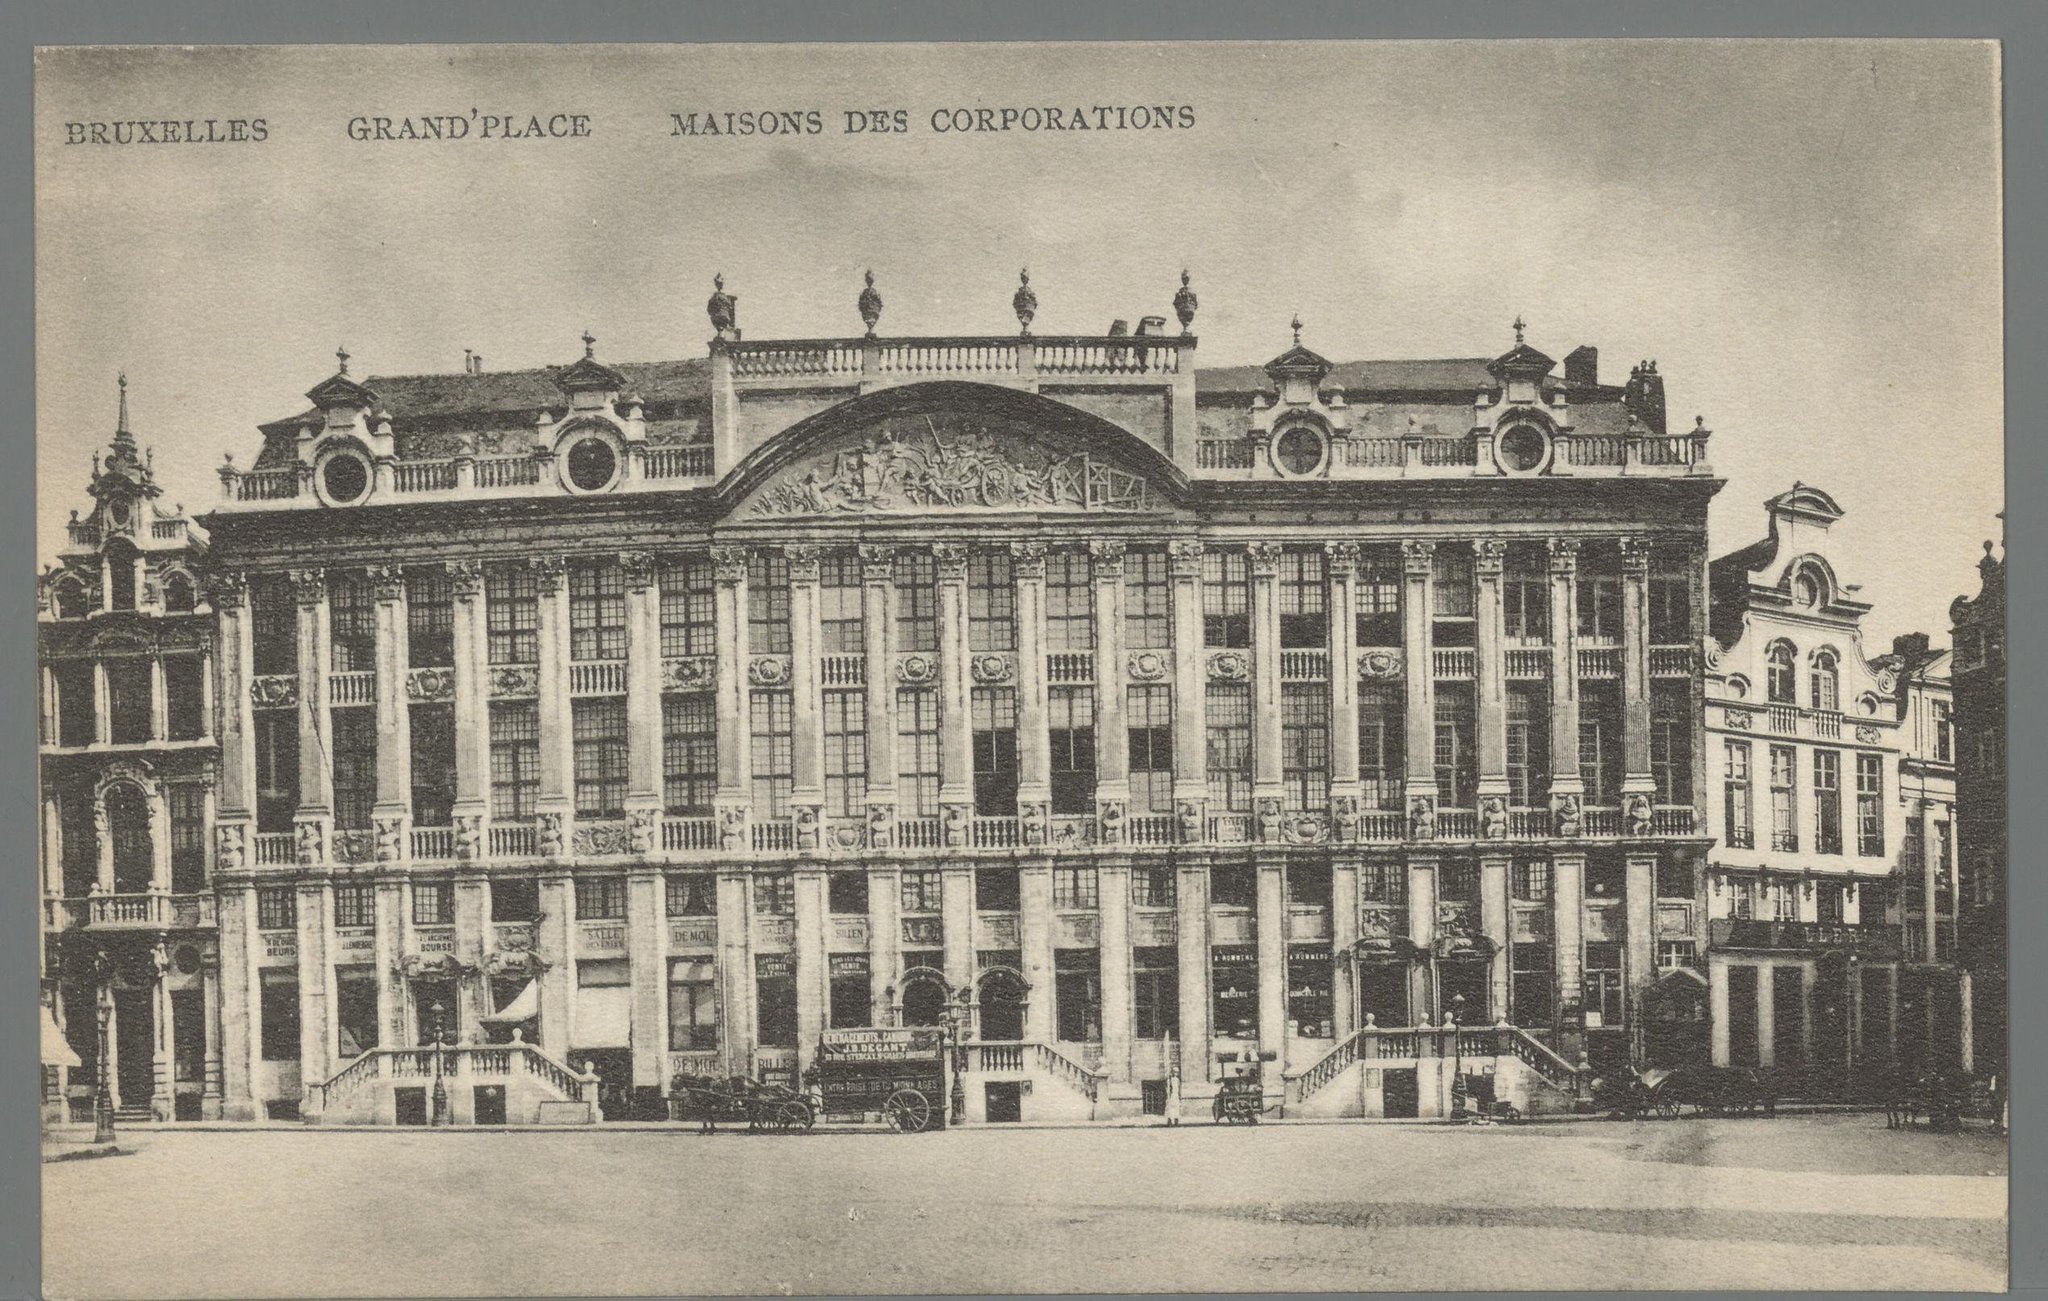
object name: photomechanical print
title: Bruxelles. Grand'Place. Maisons des corporations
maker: Anonymous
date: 1906-1930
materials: cardboard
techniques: photograph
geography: brussels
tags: square, place, circus, etc., corporative organization, guild, civic architecture; edifices; dwellings